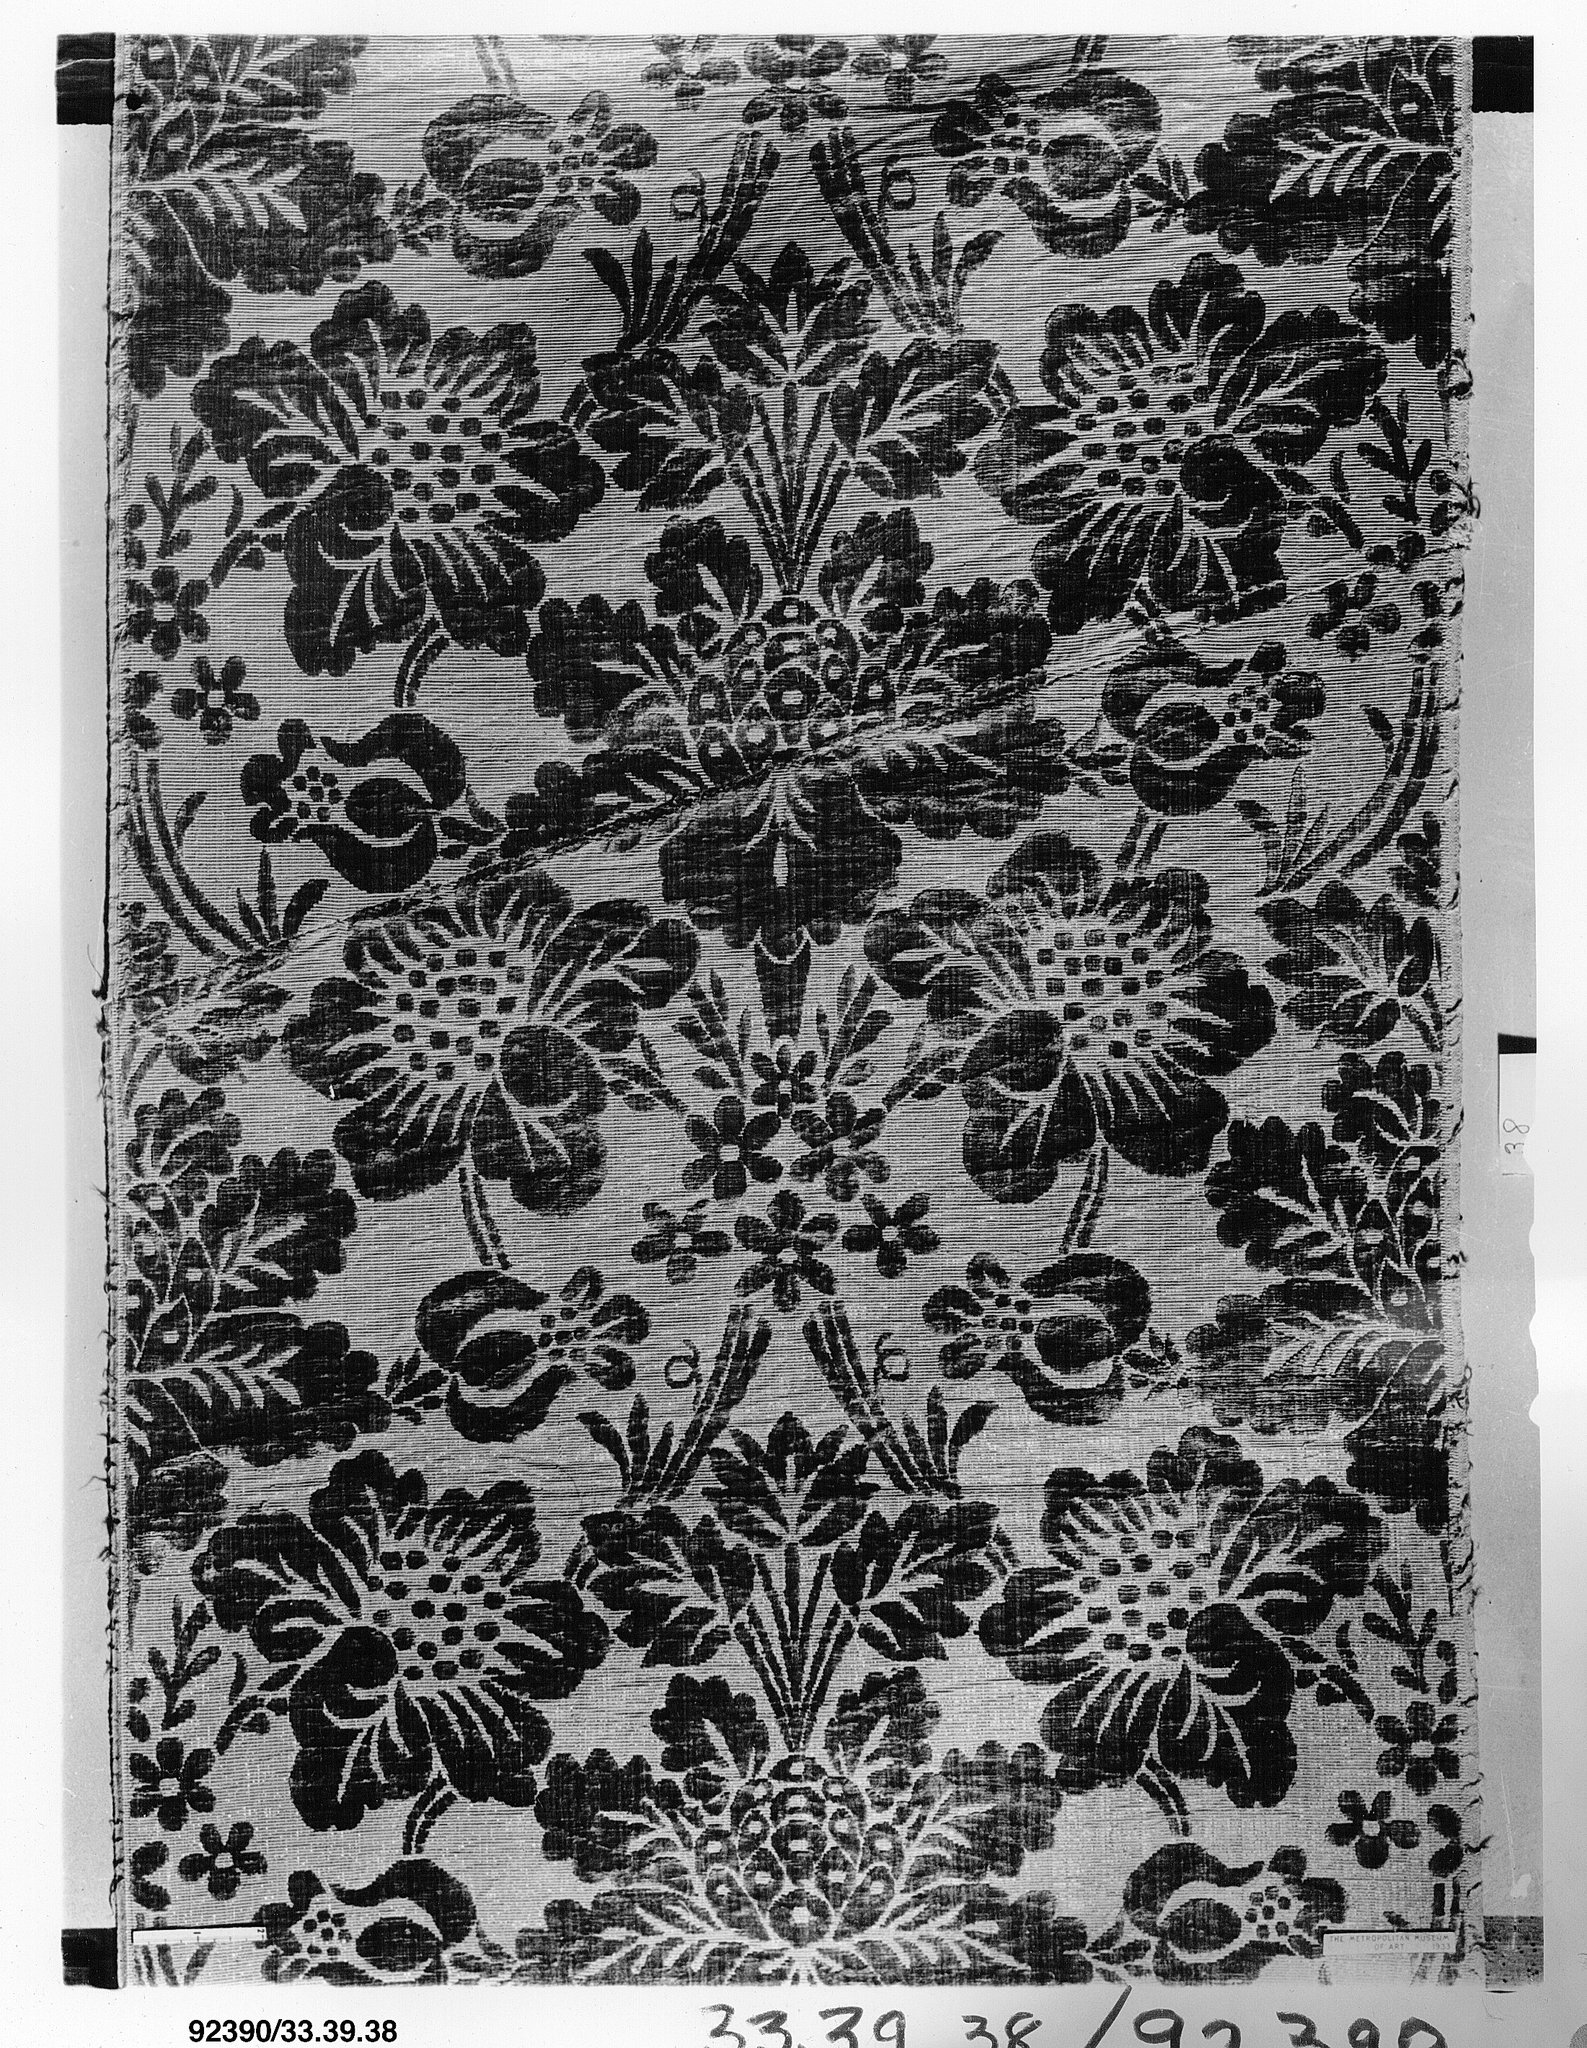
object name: piece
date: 1801-1833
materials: metal thread, silk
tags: flowers,leaves